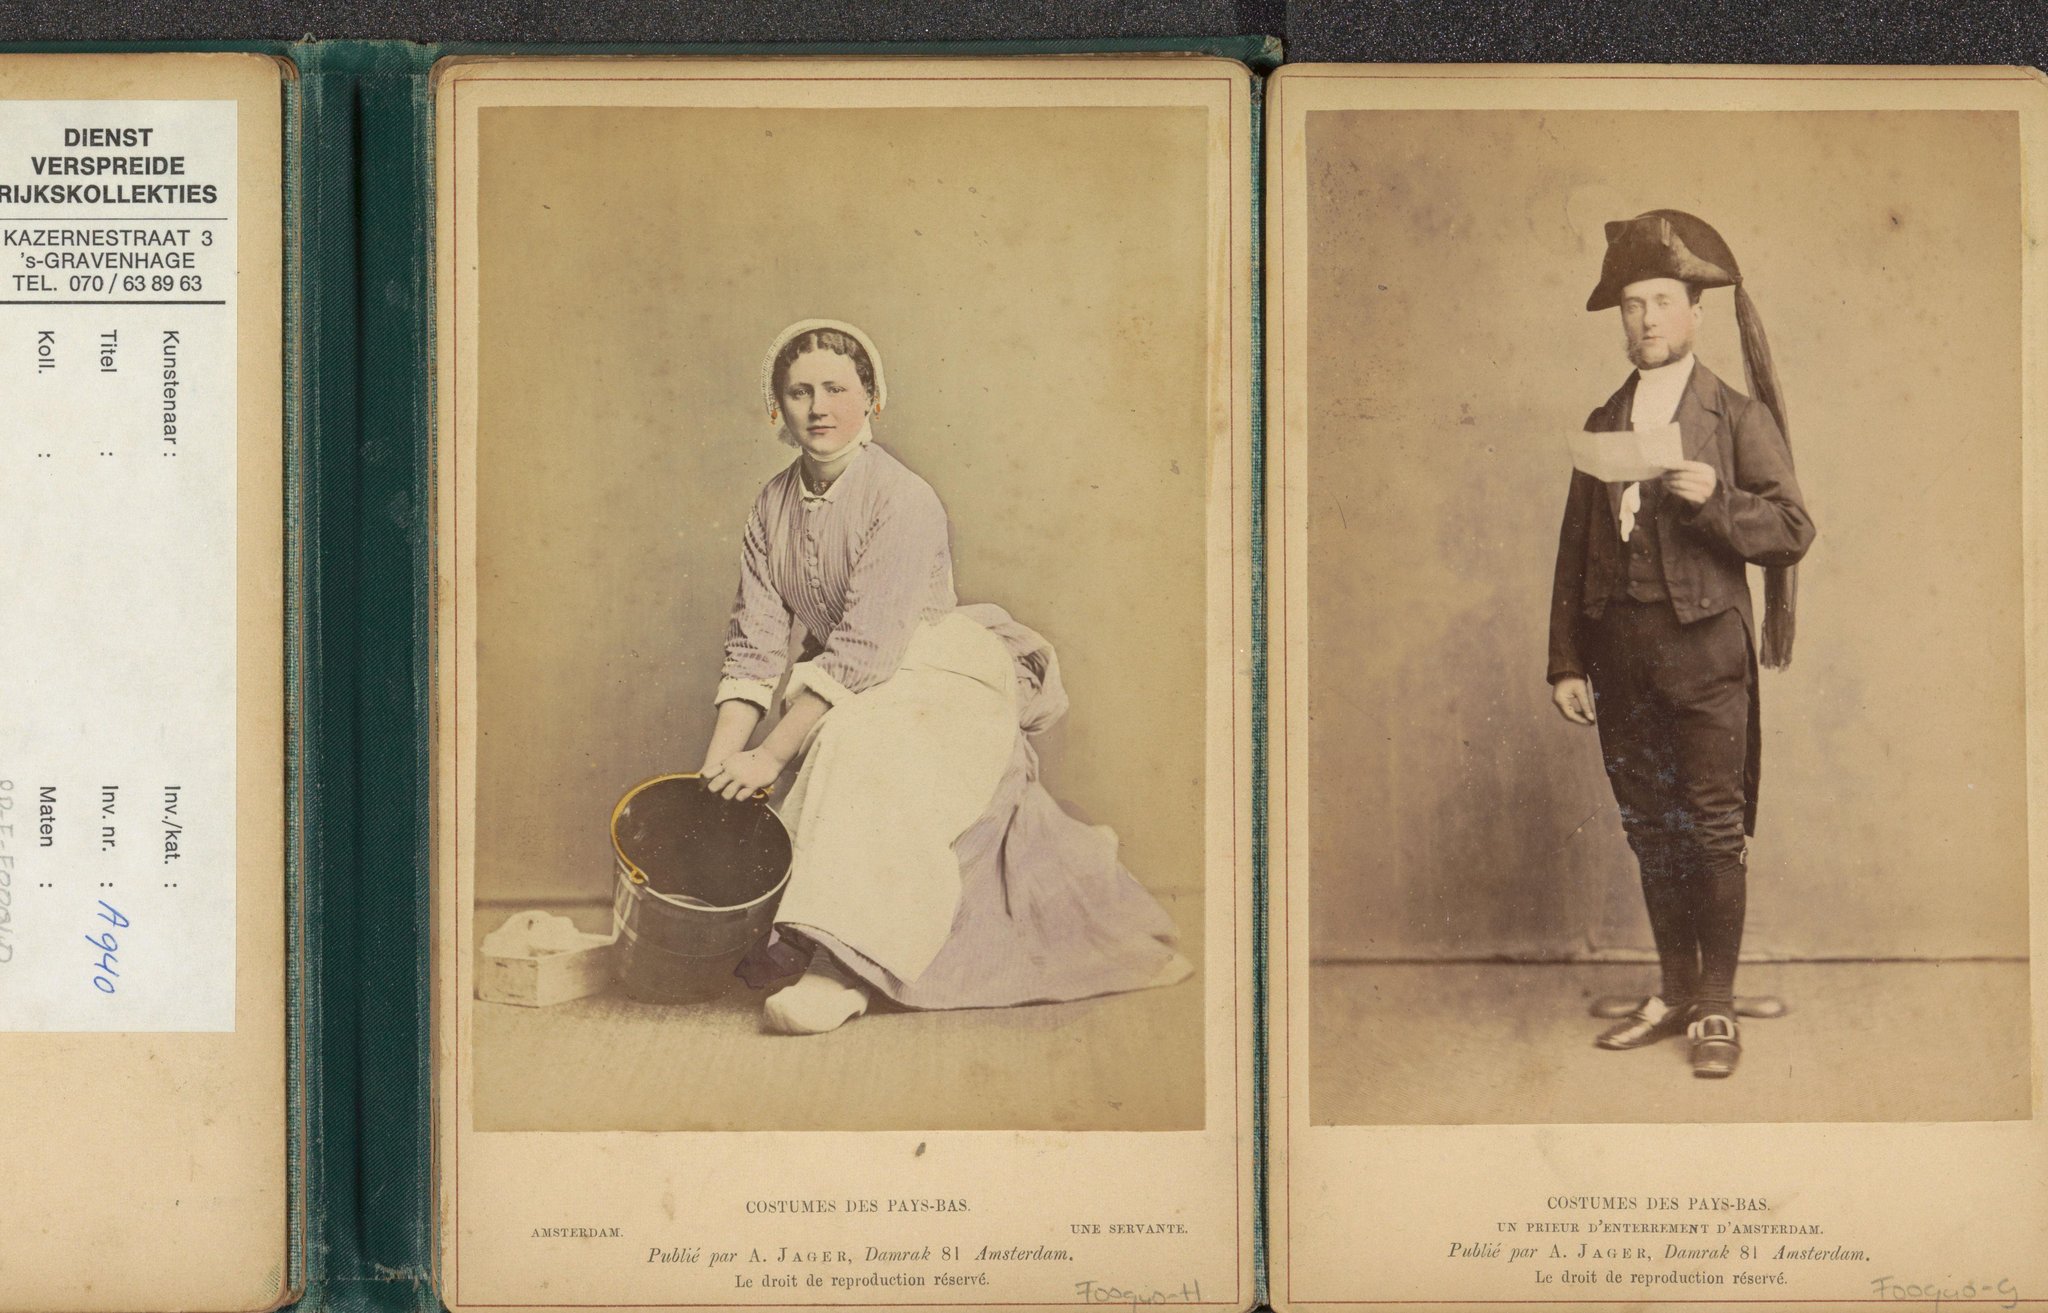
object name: photograph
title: Un prieur d'enterrement d'Amsterdam.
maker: andries jager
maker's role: publisher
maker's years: 1825-1905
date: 1870-1890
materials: cardboard, paper, photographic support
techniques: albumen print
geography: amsterdam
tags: oral announcement (of death), undertaker's man, studio requisites ~ photographer, folk costume, regional costume (+ men's clothes), folk costume, regional costume, amsterdam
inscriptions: inscription: ‘Costumes des Pays-Bas. Publiés par A. Jager, Damrak 81 Amsterdam Le droit de reproduction réservé.’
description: Onderdeel van Fotoalbum met klederdrachten van Nederland.